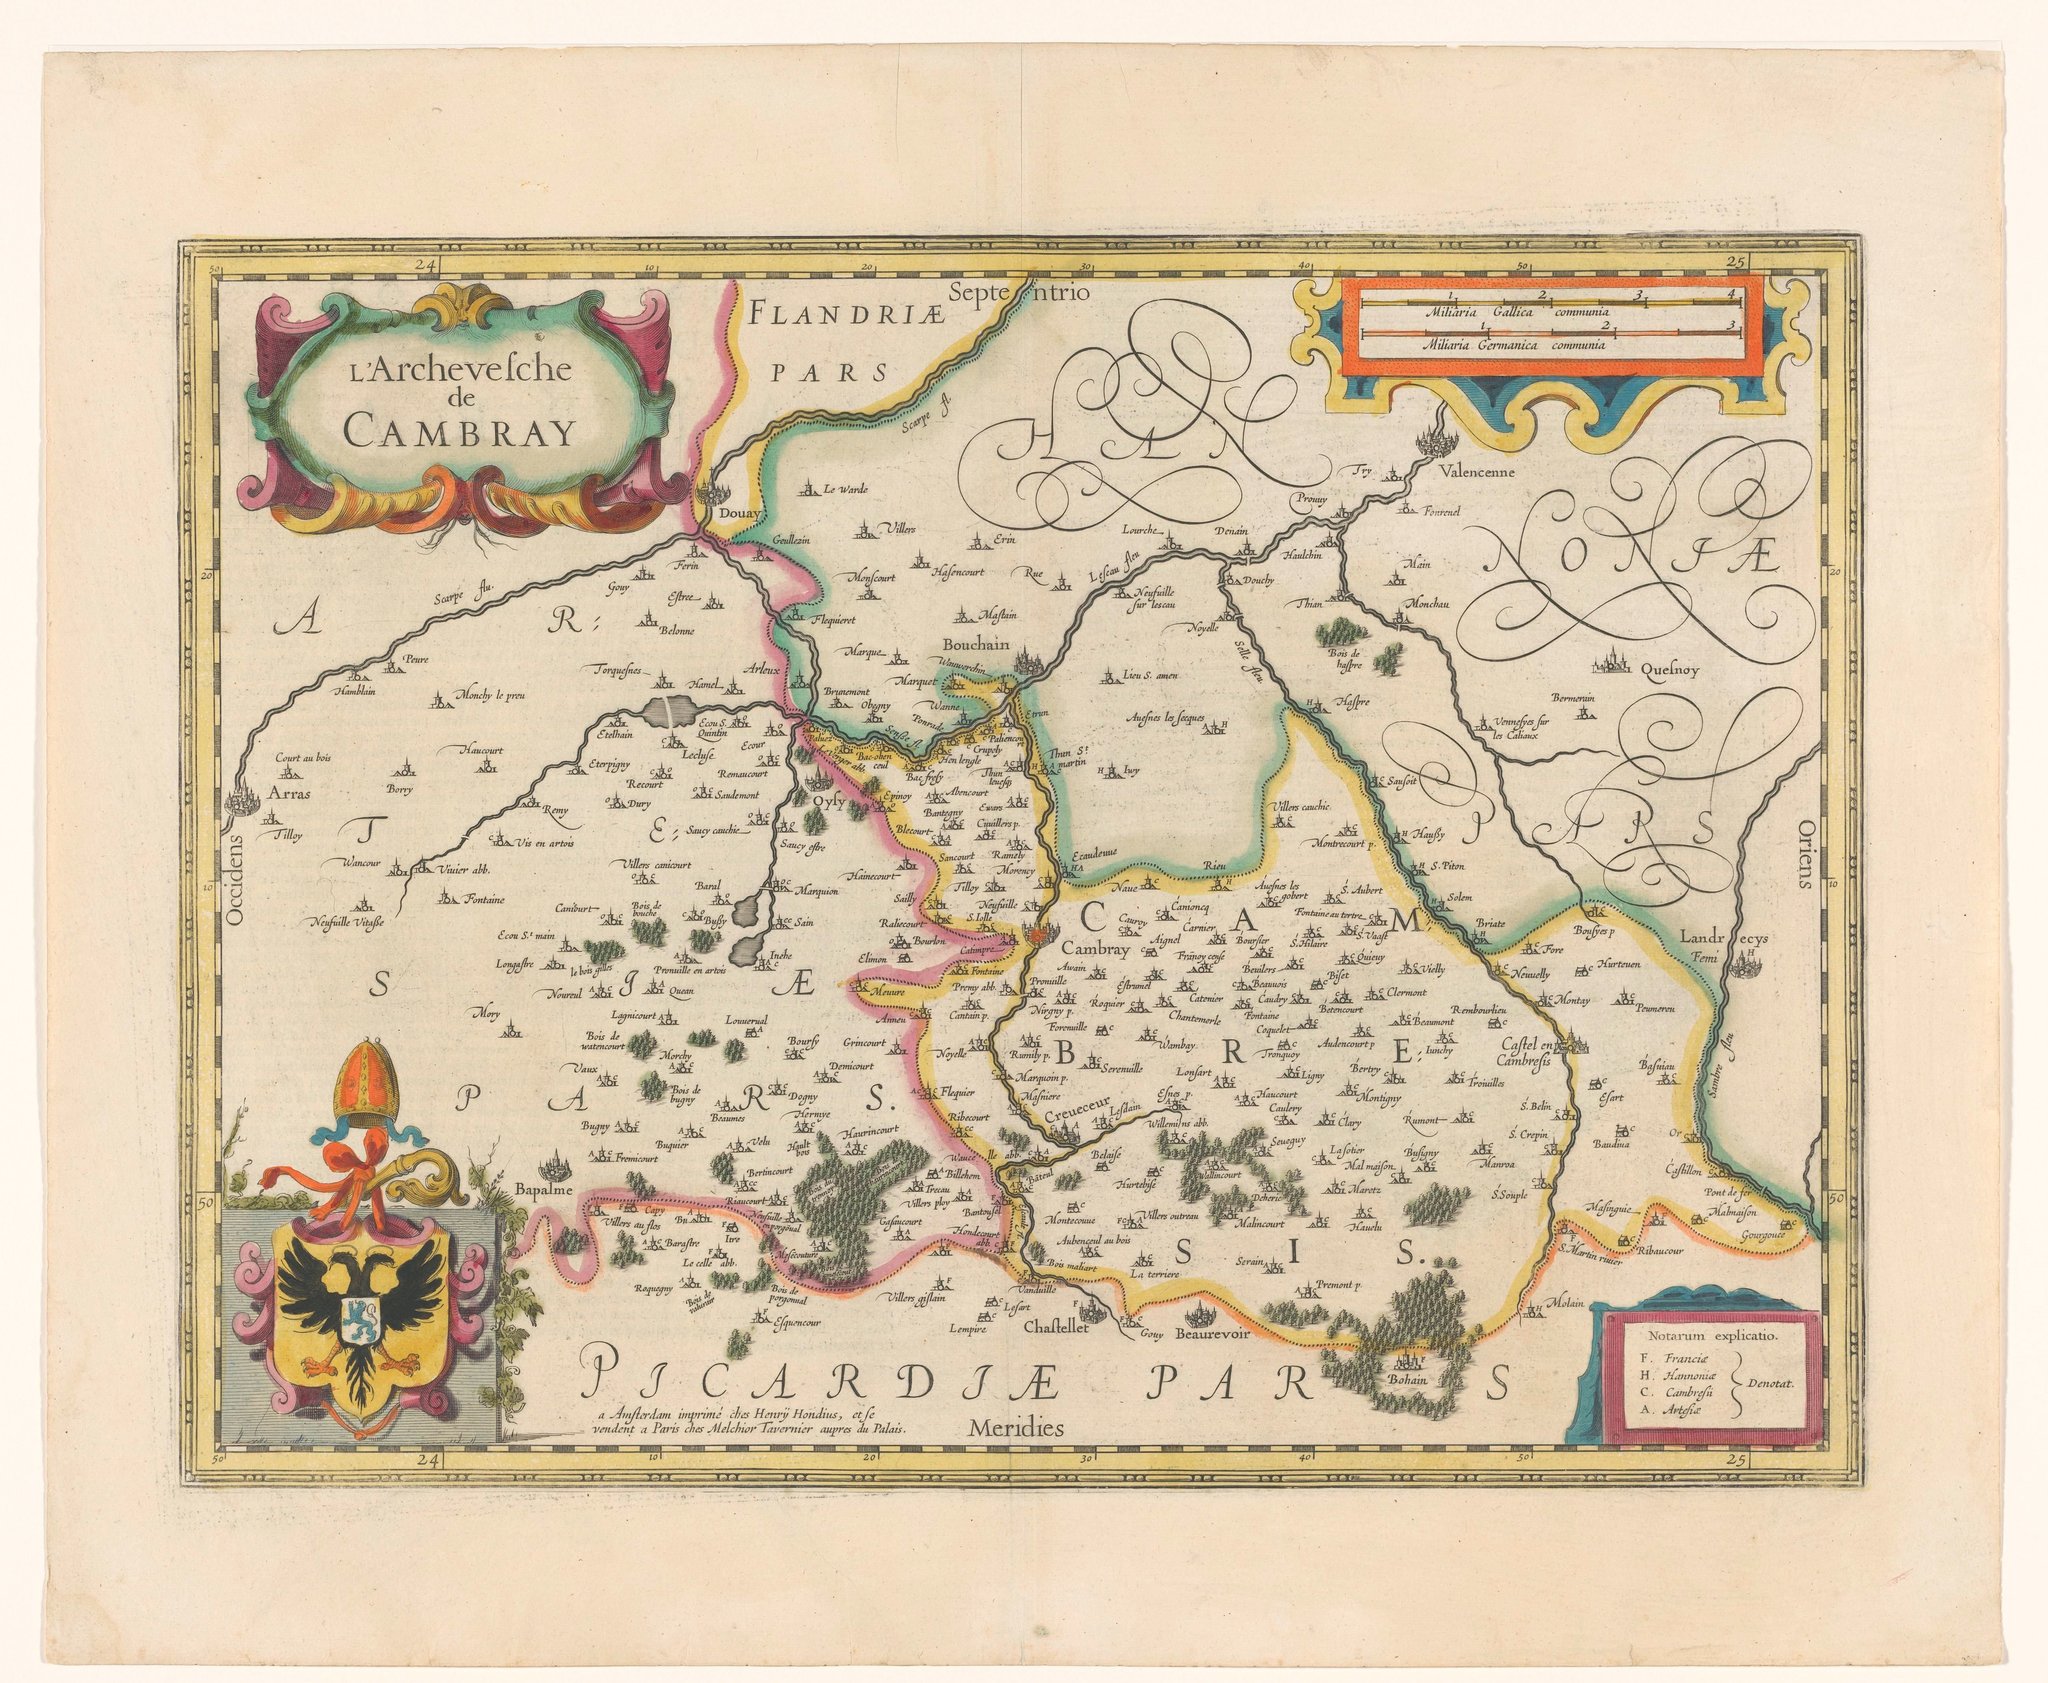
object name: map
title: Kaart van het aartsbisdom Kamerijk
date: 1633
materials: paper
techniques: engraving, hand coloring, letterpress printing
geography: paris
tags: maps of separate countries or regions, coat of arms (as symbol of the state, etc.) (+ province; provincial)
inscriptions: collector's mark: Lugt 2228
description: Kaart van het aartsbisdom Kamerijk. Linksboven de titelcartouche. Rechtsboven een cartouche met twee schaalstokken: 4 Miliaria Gallica communia / 3 Miliaria Germanica communia. Linksonder het wapen van het aartsbisdom Kamerijk. Rechtsonder een cartouche met uitleg van de afkortingen op de kaart. De kaart is voorzien van een gradenverdeling langs de randen. Met Franse tekst op verso.